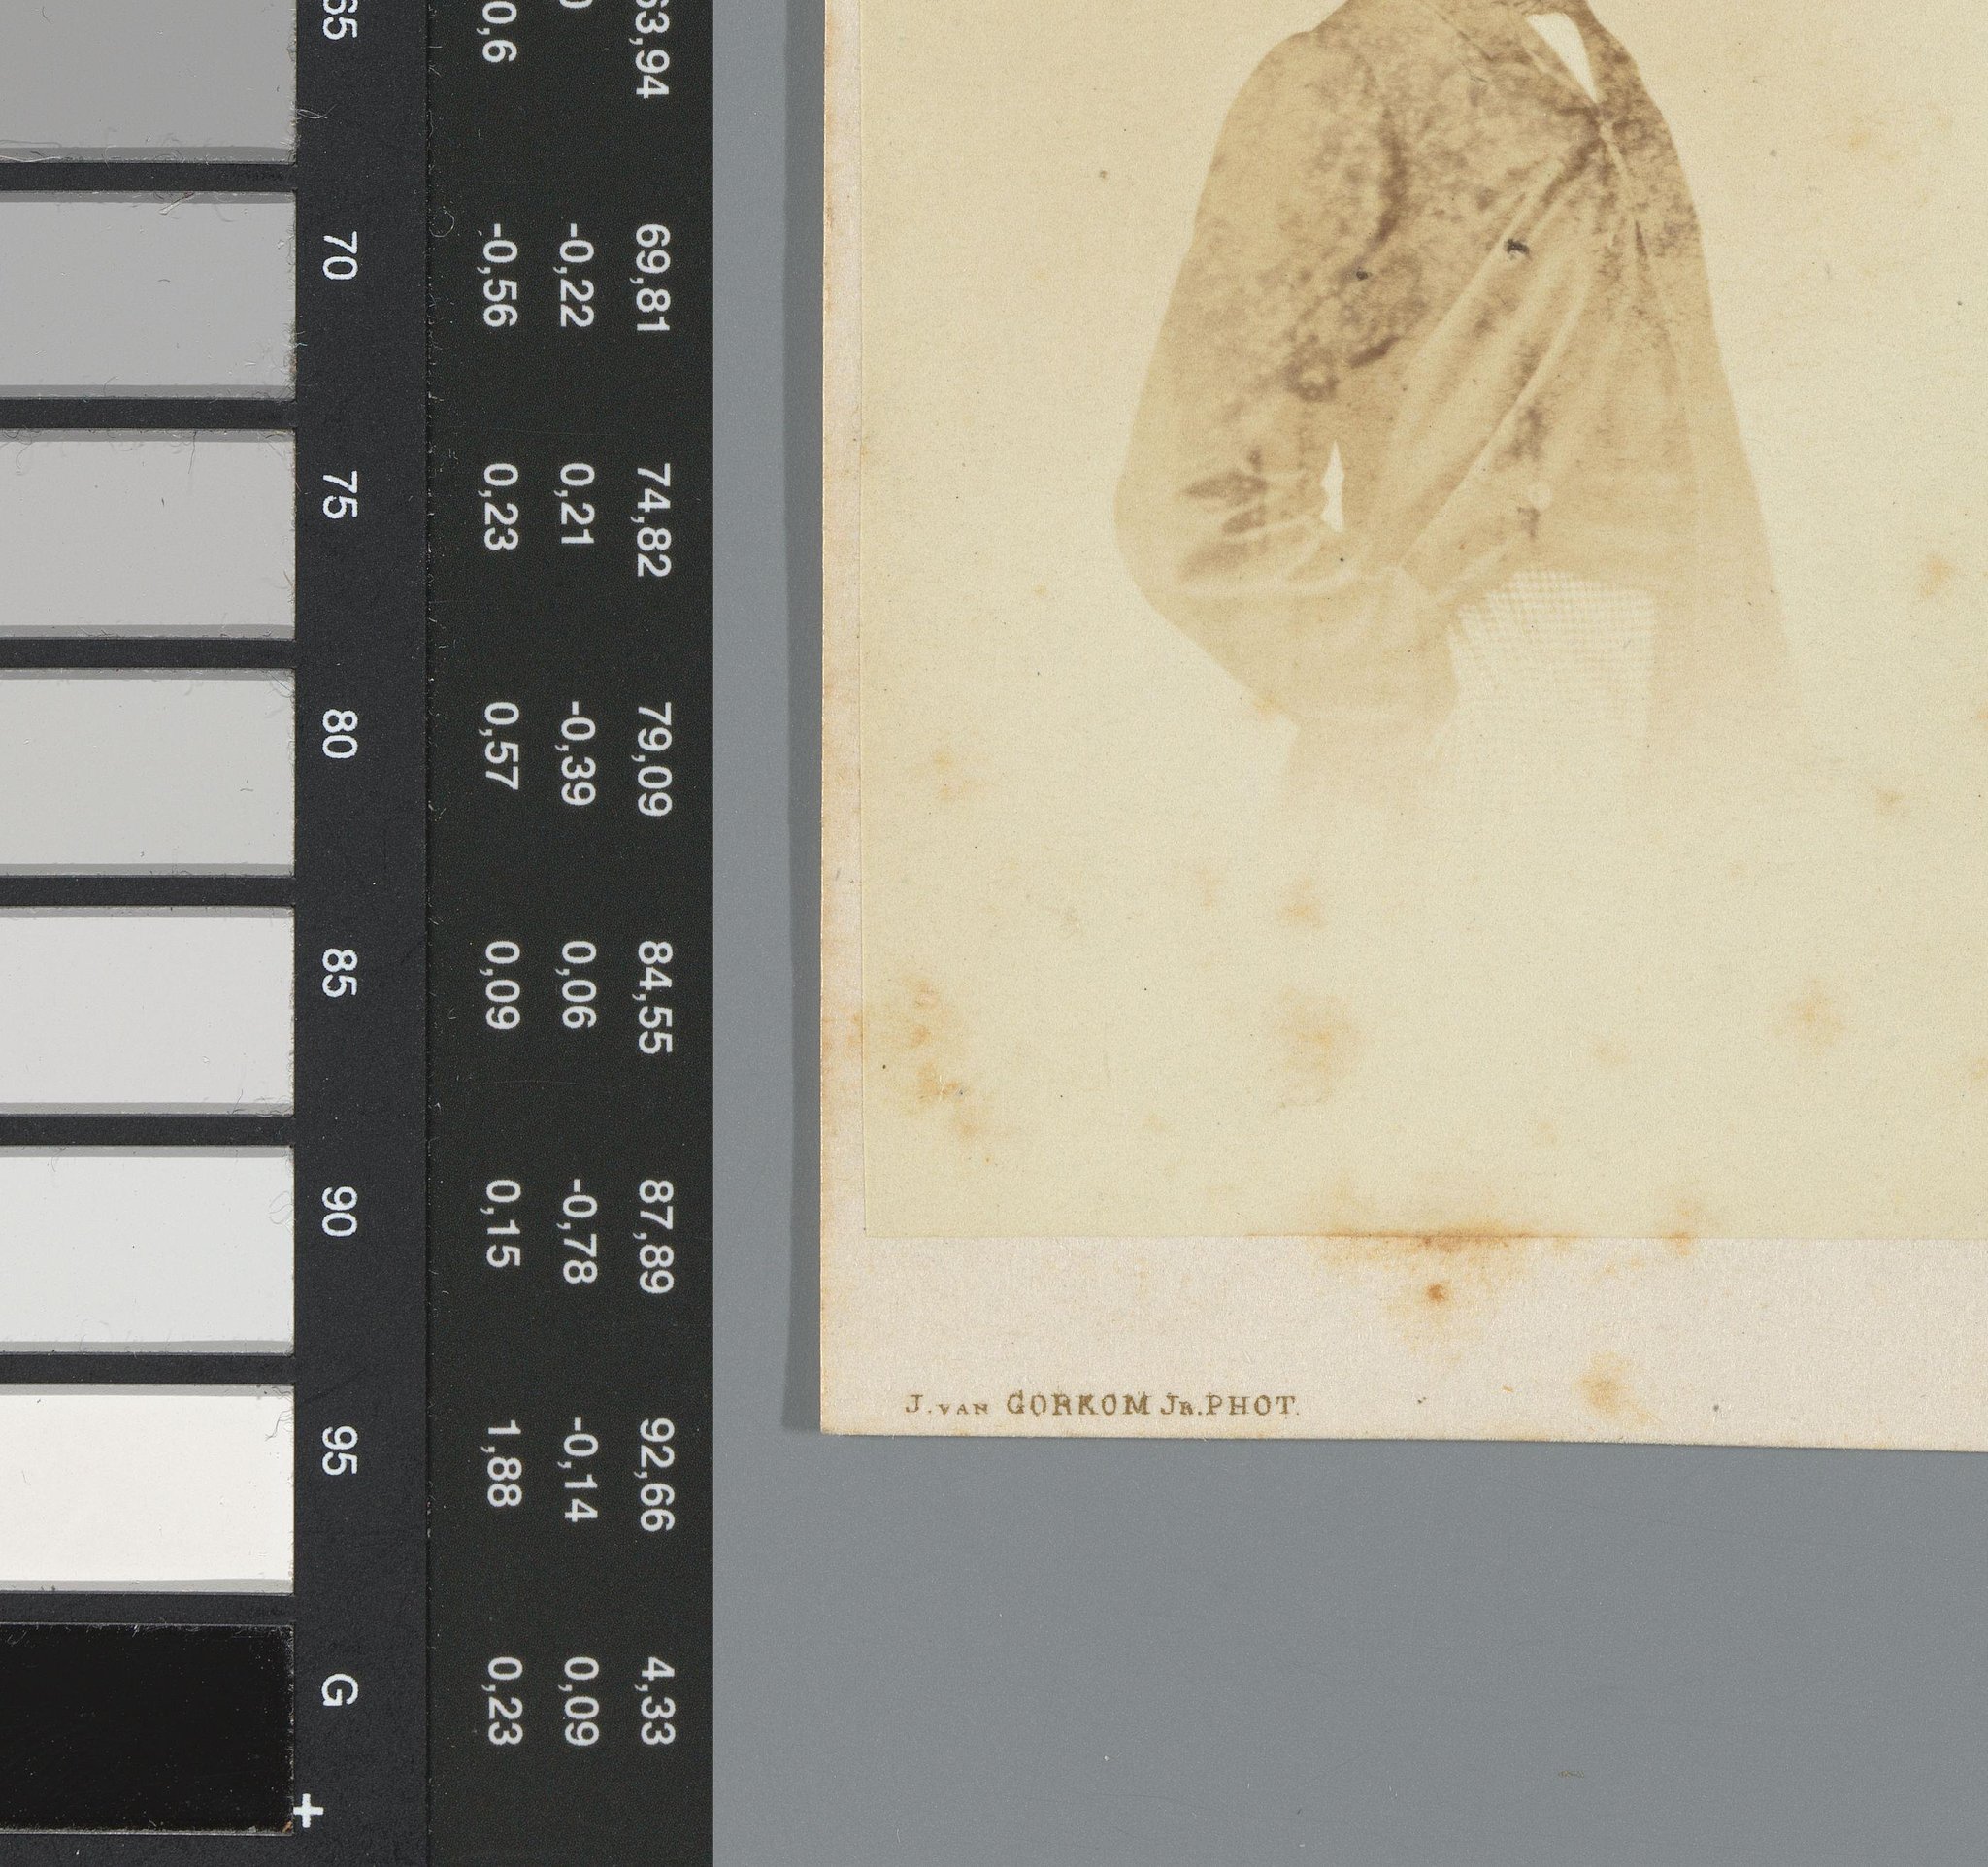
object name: carte de visite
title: Portret van Franciscus Johannes van den Berg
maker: jacobus van gorkom (jr.)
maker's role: print maker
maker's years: 1827-1880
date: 1855-1910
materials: cardboard, photographic support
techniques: albumen print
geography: rotterdam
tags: rotterdam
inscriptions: name: ‘J. VAN GORKOM JR. / PHOTOGRAPHE / ROTTERDAM / KRUISKADE / WIJK . 14 . 592’, name: ‘J. VAN GORKOM JR. PHOT’, inscription: ‘oom frans v.d. Berg / professor in Delft / 1833 - 1892’